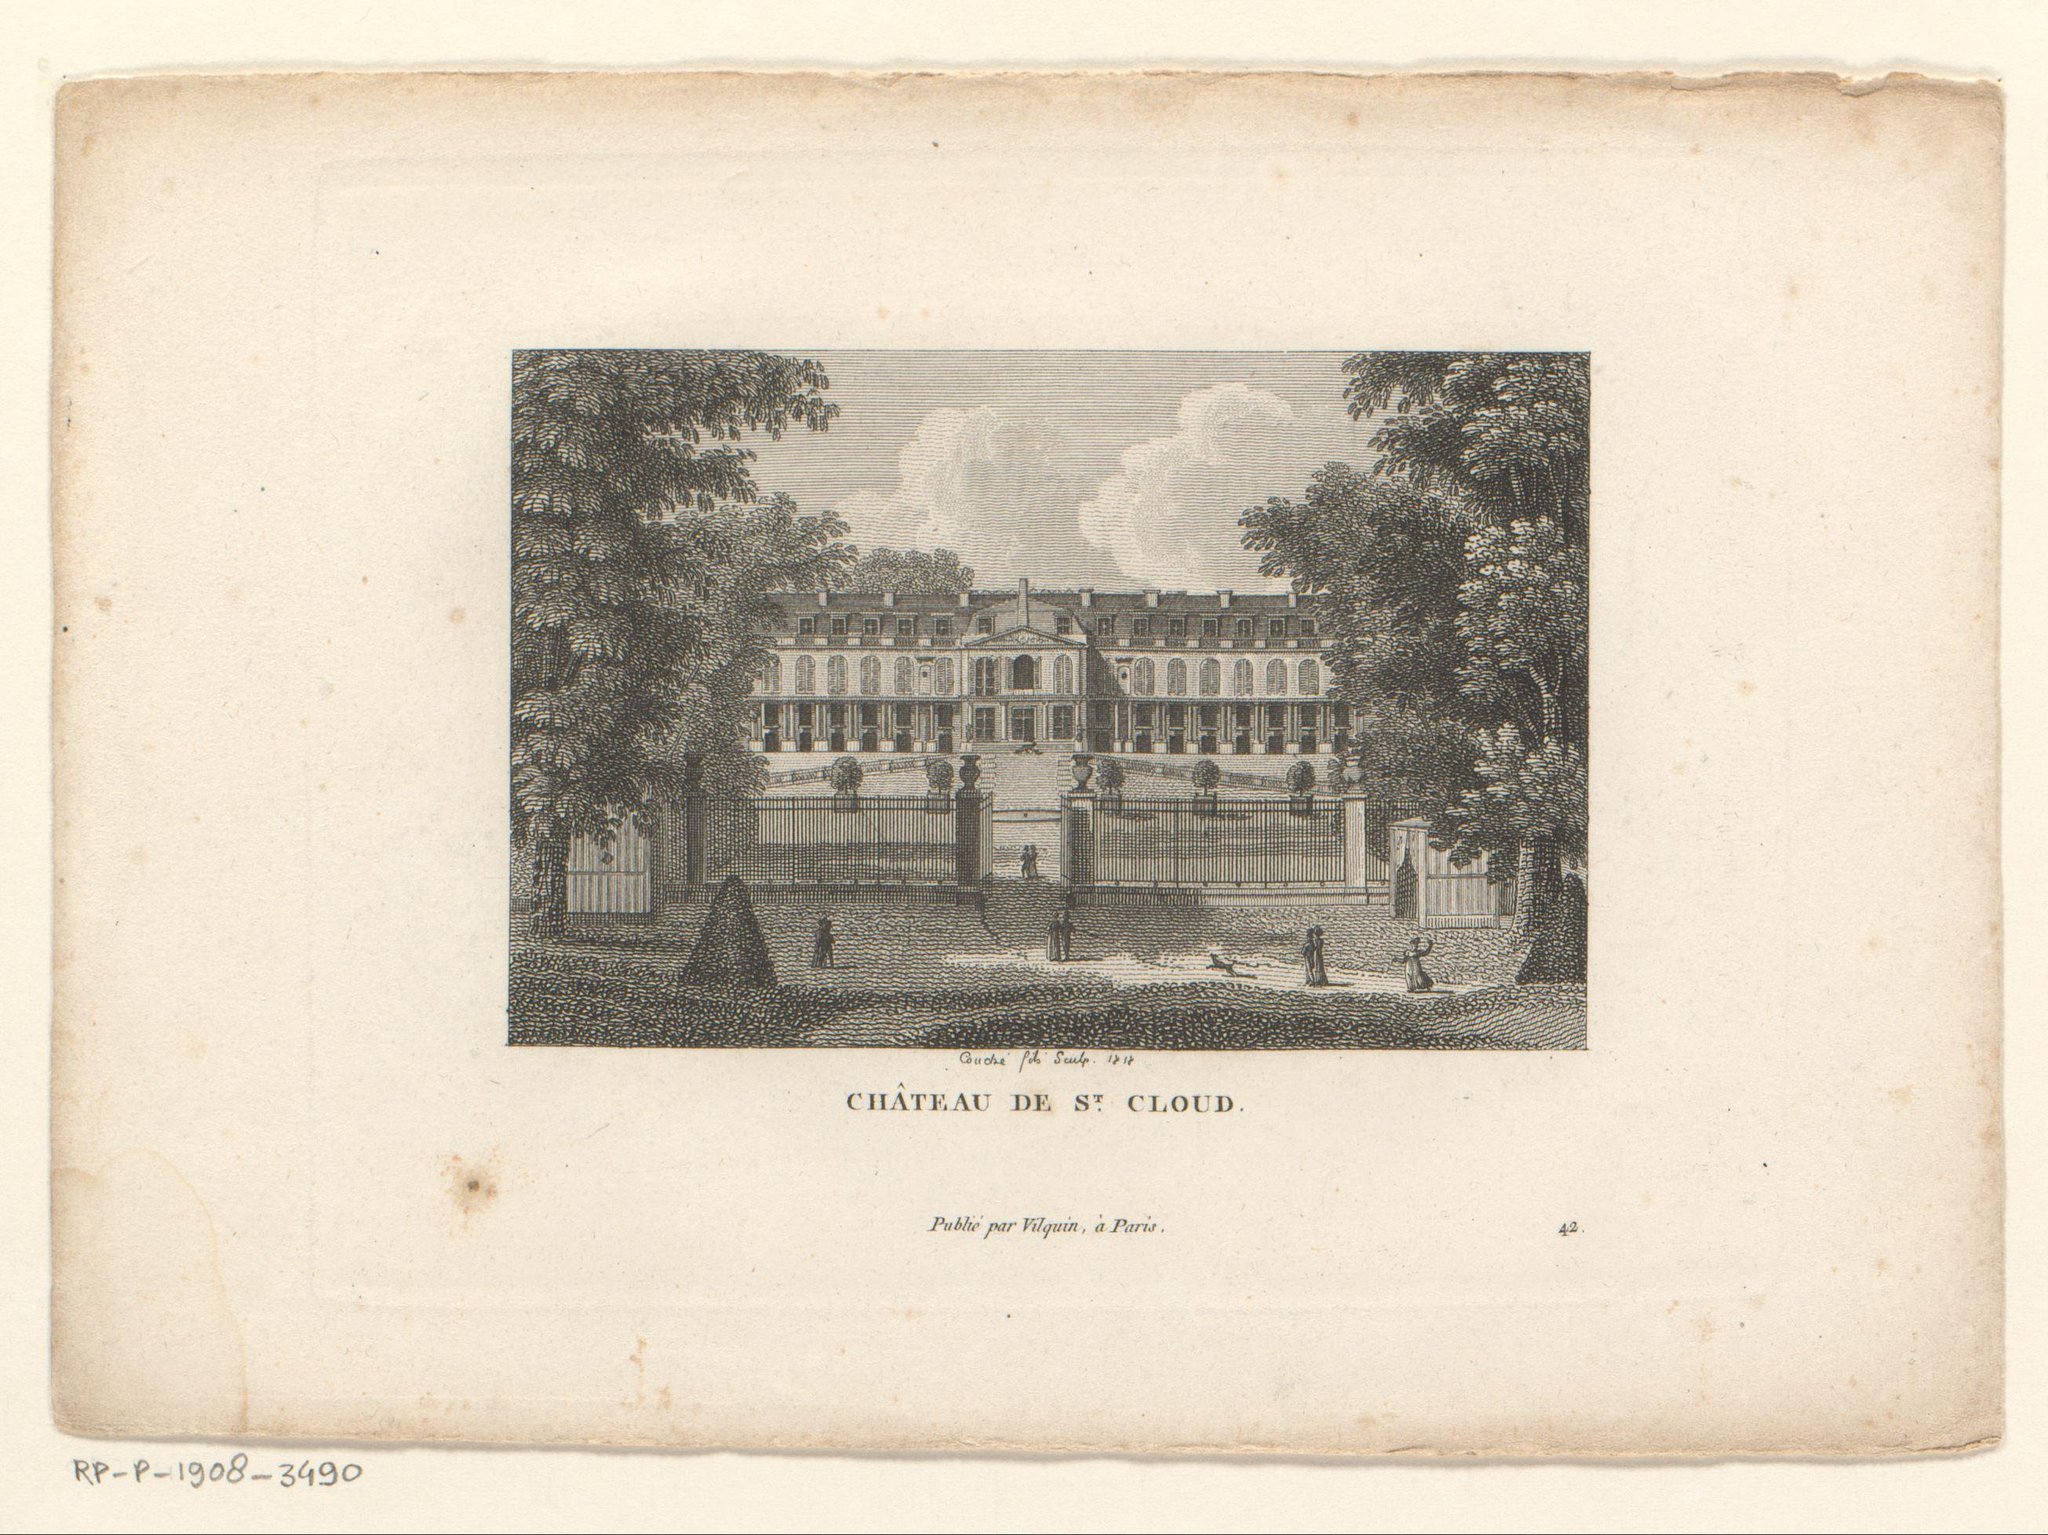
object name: print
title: Gezichten op Parijs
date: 1818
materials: paper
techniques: etching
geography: paris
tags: city-view in general; 'veduta', palace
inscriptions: collector's mark: Lugt 2228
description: Maakt deel uit van een serie met 60 platen van monumenten, kathedralen en paleizen in Parijs.